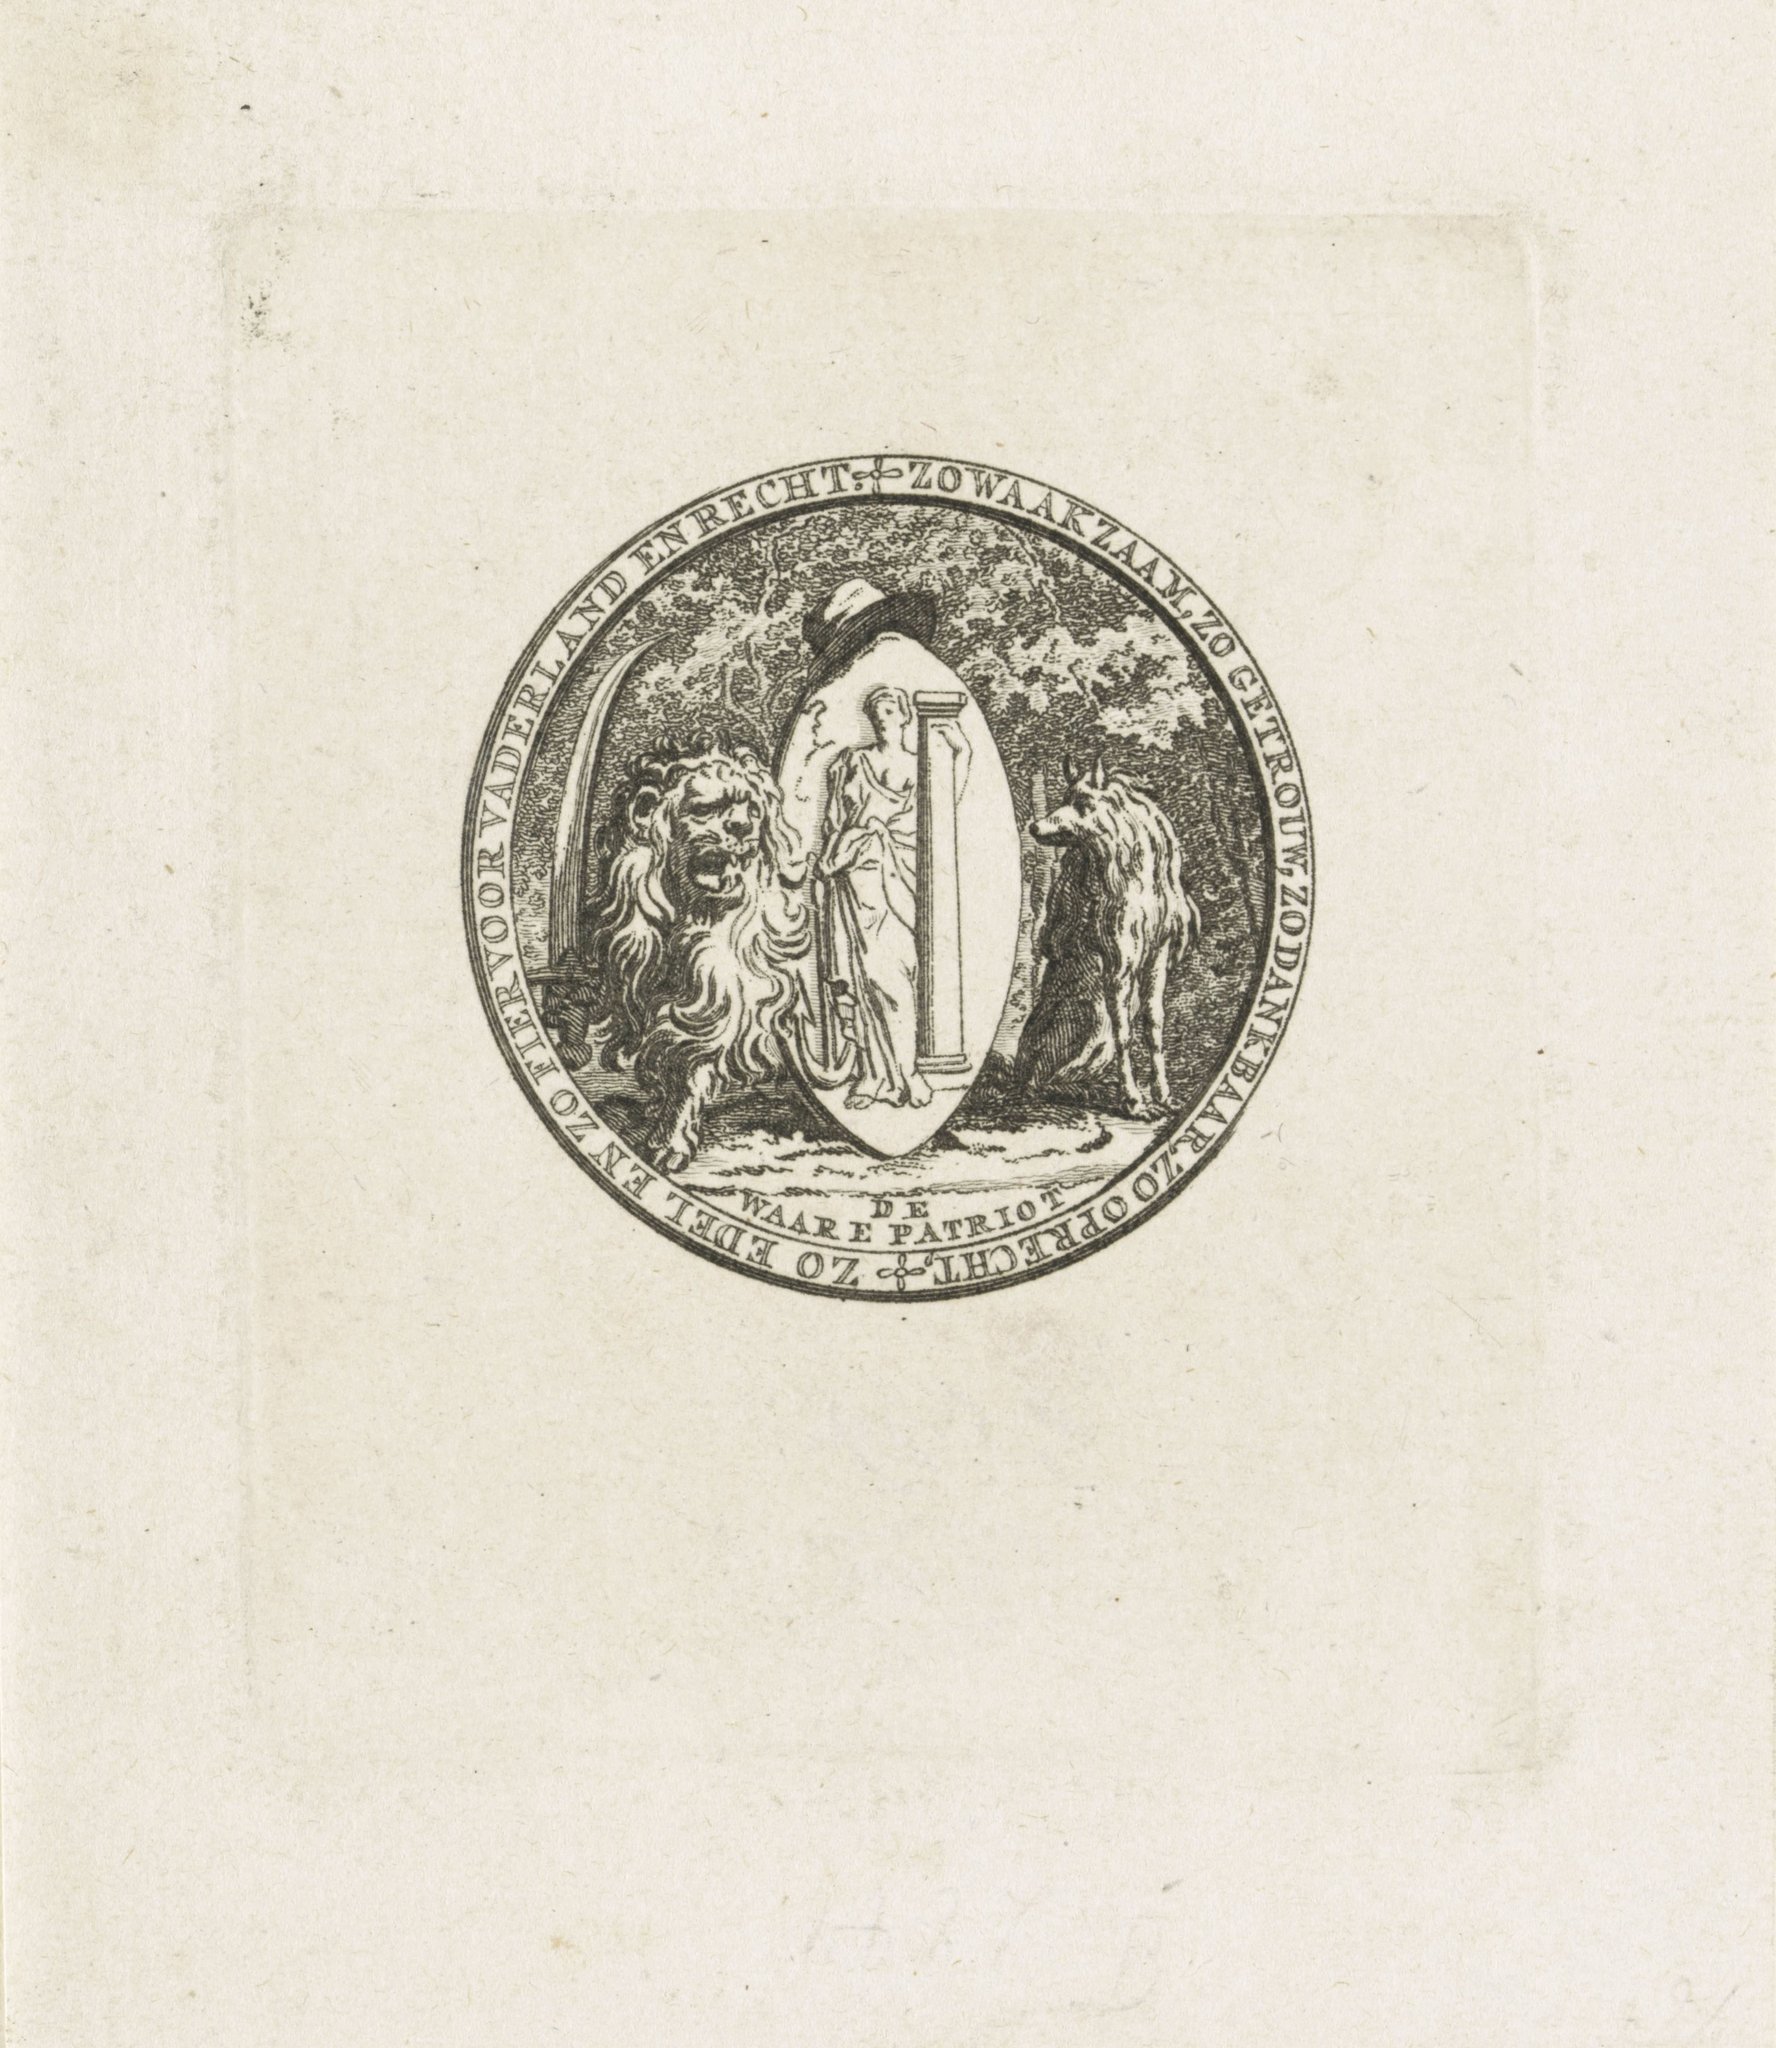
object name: print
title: Medaillon voor de Waare Patriot, ca. 1784-1792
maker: Anonymous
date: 1784-1792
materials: paper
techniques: etching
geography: northern netherlands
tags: medal (considered as a piece of sculpture, regardless of its specific function), patriots (1780-1795)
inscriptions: collector's mark: Lugt 2228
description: Medaillon of plaquette met een schild met een vrouw staande naast een zuil (Standvastigheid) en een anker (Hoop), ca. 1784-1792. Op het schild rust de vrijheidshoed. Ter weerszijden de Nederlandse leeuw en een keeshond. Met randschrift.